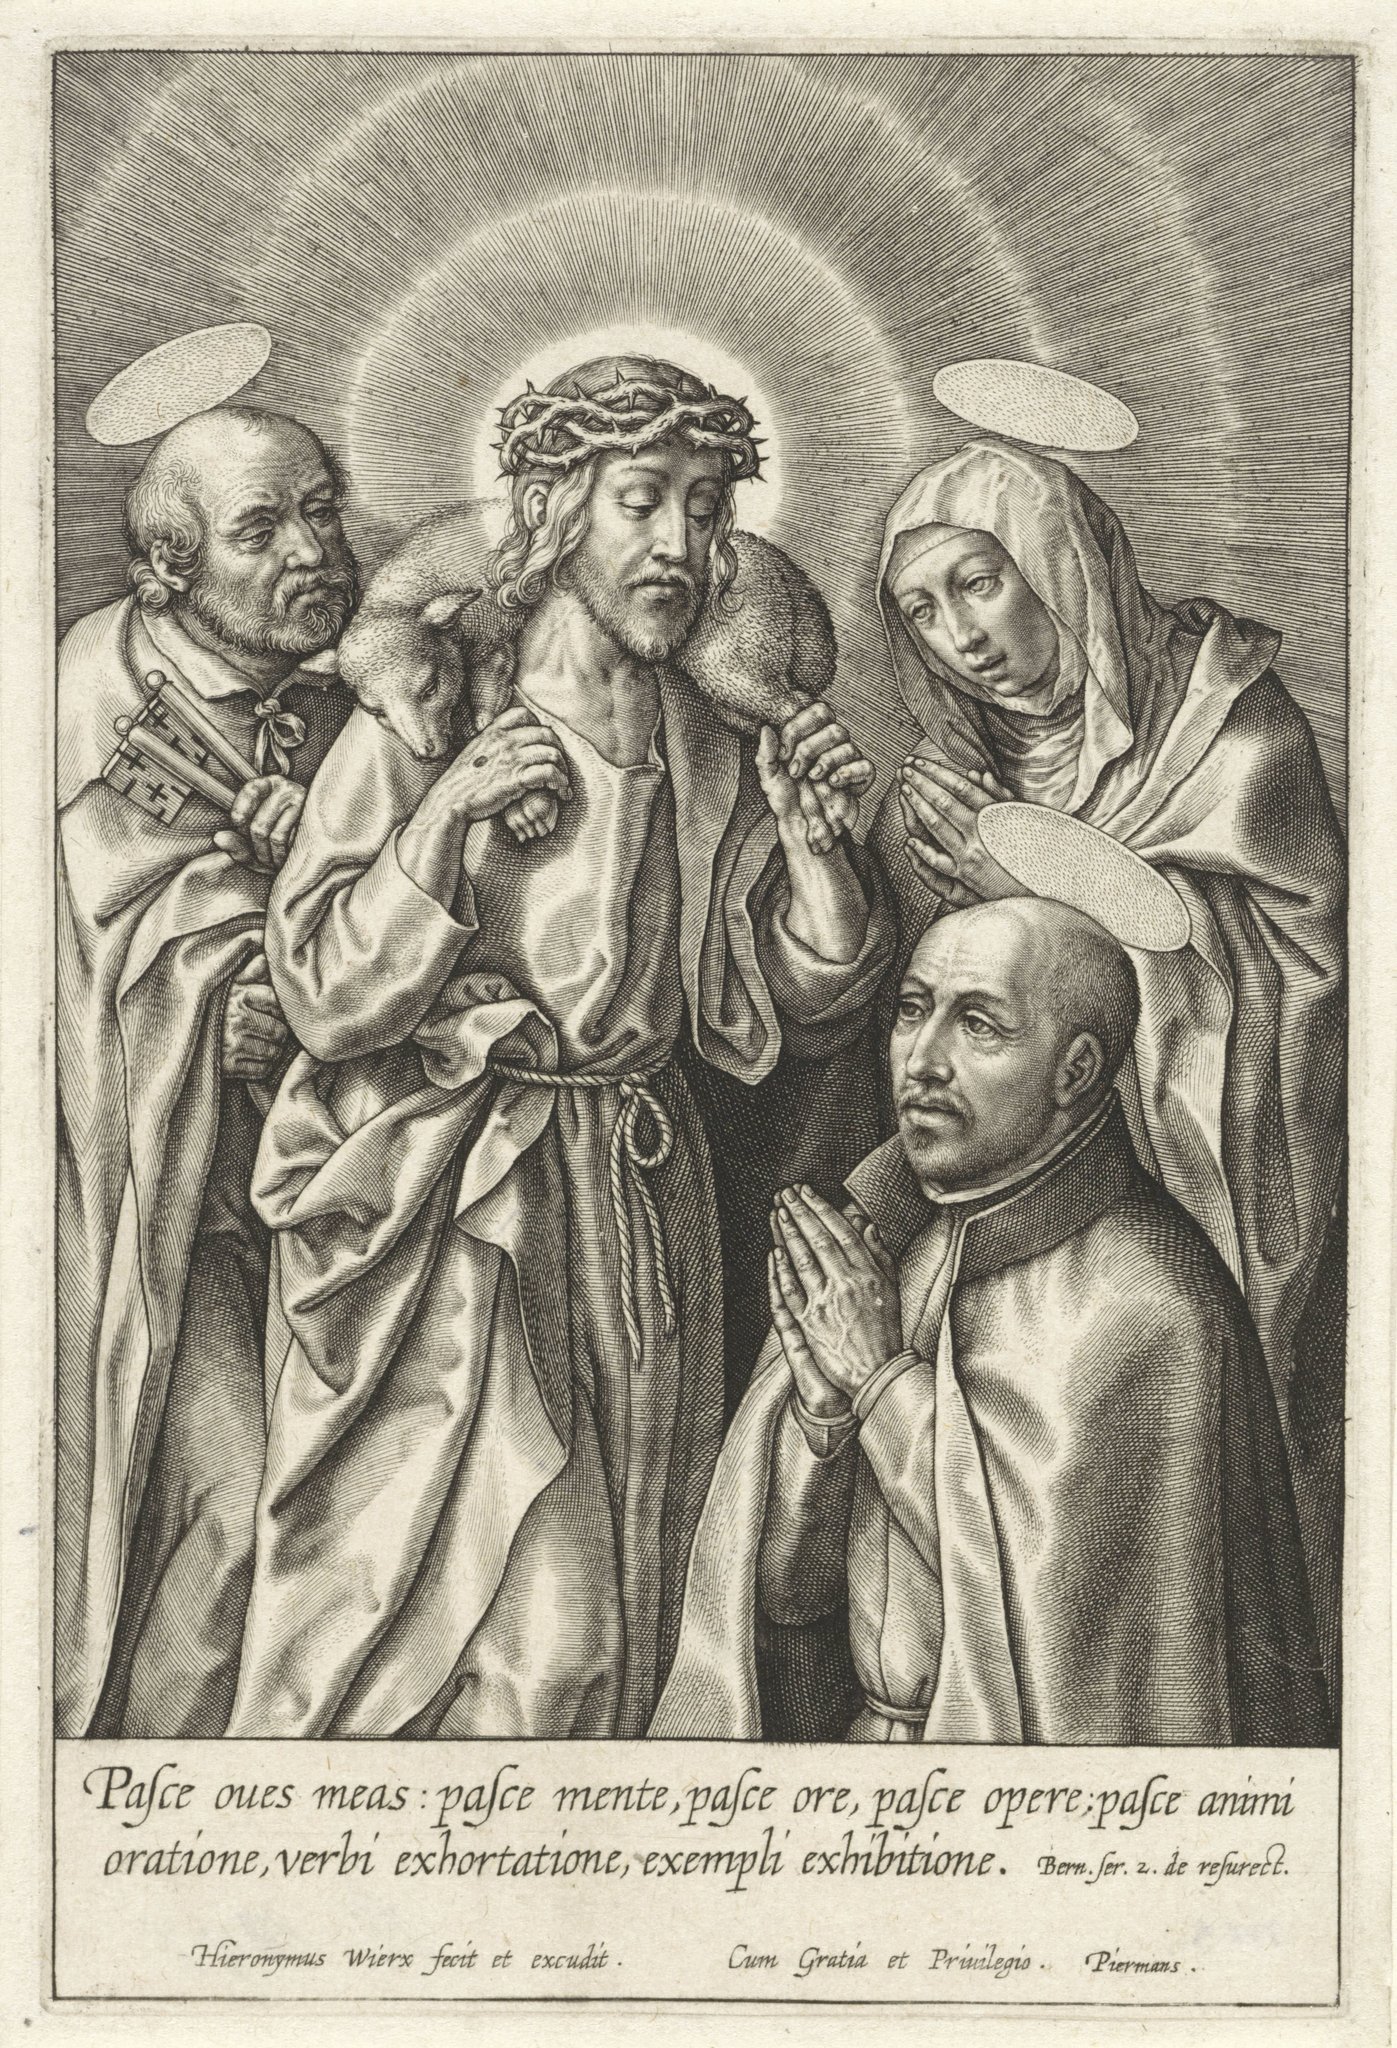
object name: print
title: Ignatius van Loyola knielt voor Christus als de Goede Herder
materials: paper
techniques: engraving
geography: antwerp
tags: rome, clergyman, the virgin mary, christ as good shepherd, the founder of the jesuit order, ignatius of loyola; possible attributes: book (with 'ad majorem dei gloriam'), demon, dragon under feet, flames, flaming heart, globe, ihs monogram, skull (with crown), tears in eyes, torch, the apostle peter, first bishop of rome; possible attributes: book, cock, (upturned) cross, (triple) crozier, fish, key, scroll, ship, tiara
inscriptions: collector's mark: Lugt 2228, collector's mark: Lugt 2542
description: Ignatius van Loyola knielt met gevouwen handen voor Christus die een lam op zijn rug draagt. Christus wordt geflankeerd door Petrus en Maria. In de marge een tweeregelig onderschrift in het Latijn.